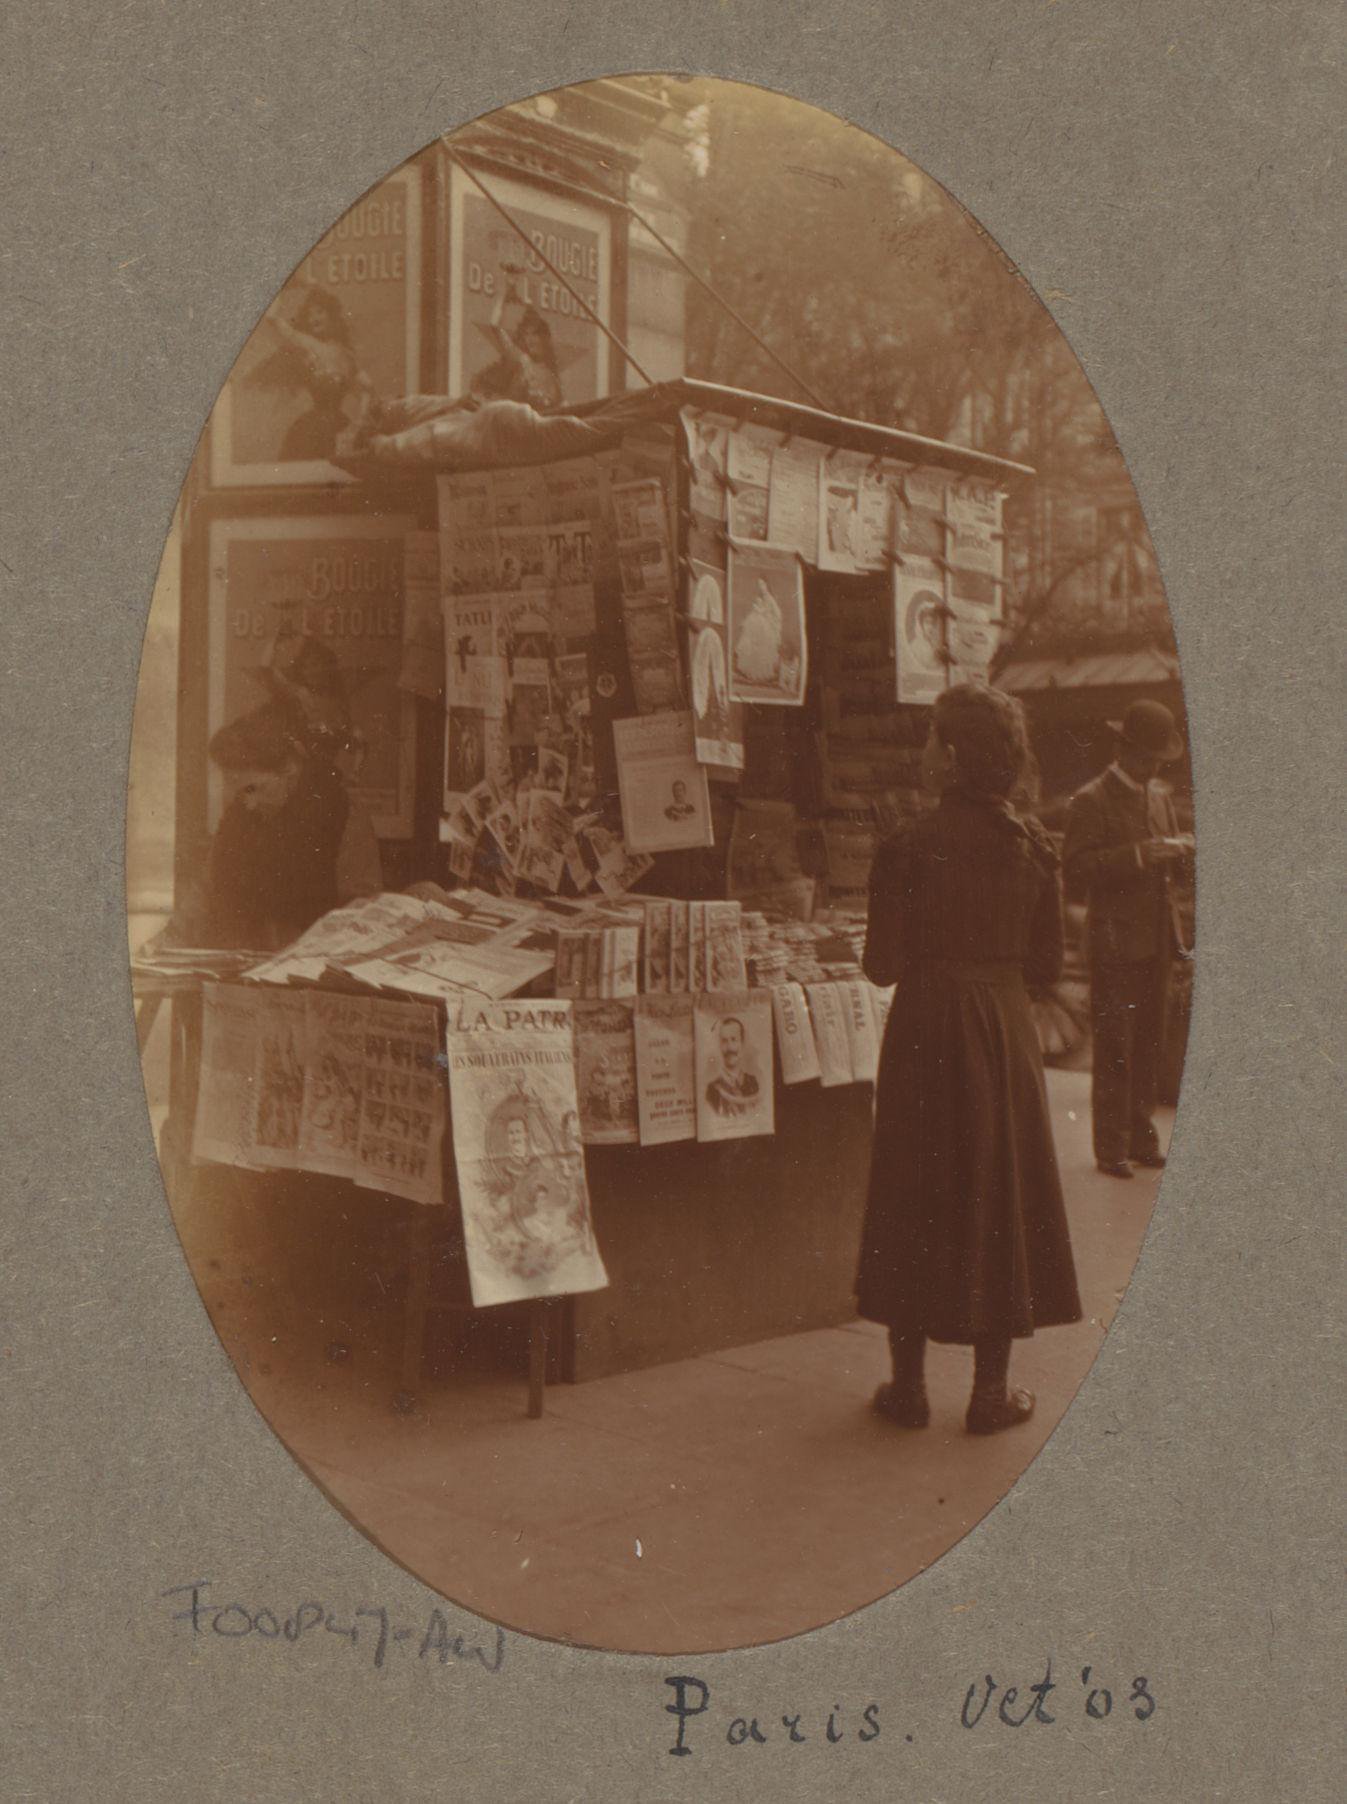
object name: album leaf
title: Meisje bekijkt krantenkiosk op straat in Parijs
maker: Anonymous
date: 1903-1910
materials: cardboard, paper, photographic support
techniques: gelatin silver print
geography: paris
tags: sale of newspaper, newspaper stand, newspaper, news-sheet, paris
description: Onderdeel van Reisalbum van een Nederlandse familie met bezienswaardigheden in Europa, Egypte en New York.